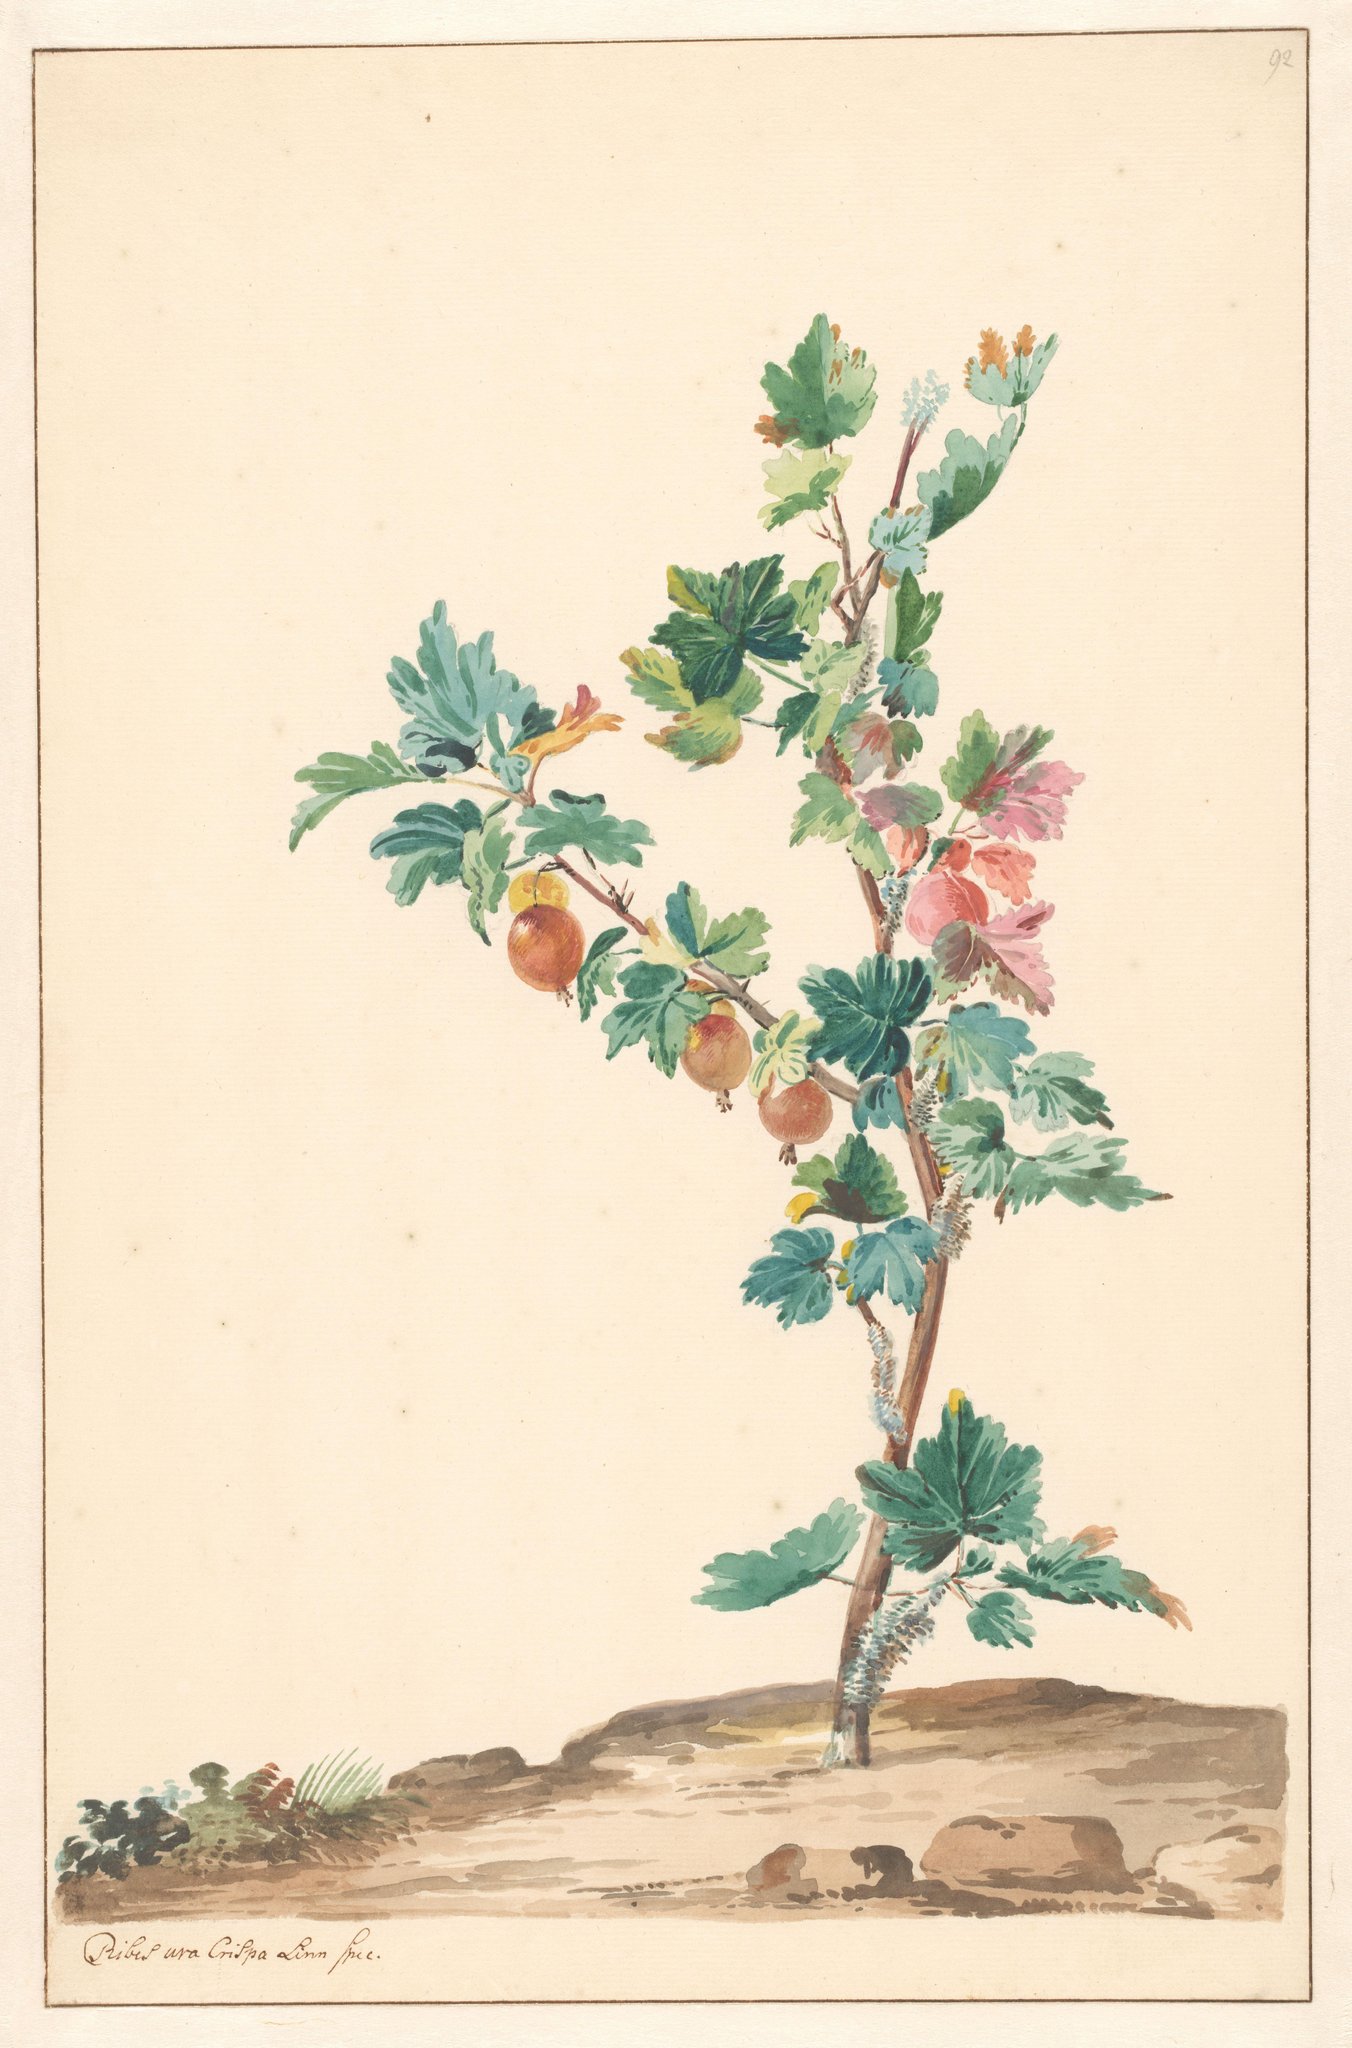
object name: drawing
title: Een kruisbes in een landschap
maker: willem van leen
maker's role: draughtsman, print maker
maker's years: 1753-1825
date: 1775-1825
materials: gouache, pencil, watercolor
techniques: brush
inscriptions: annotation: ‘Ribes ura Crispa Linn Spec.’, inscription: ‘92’